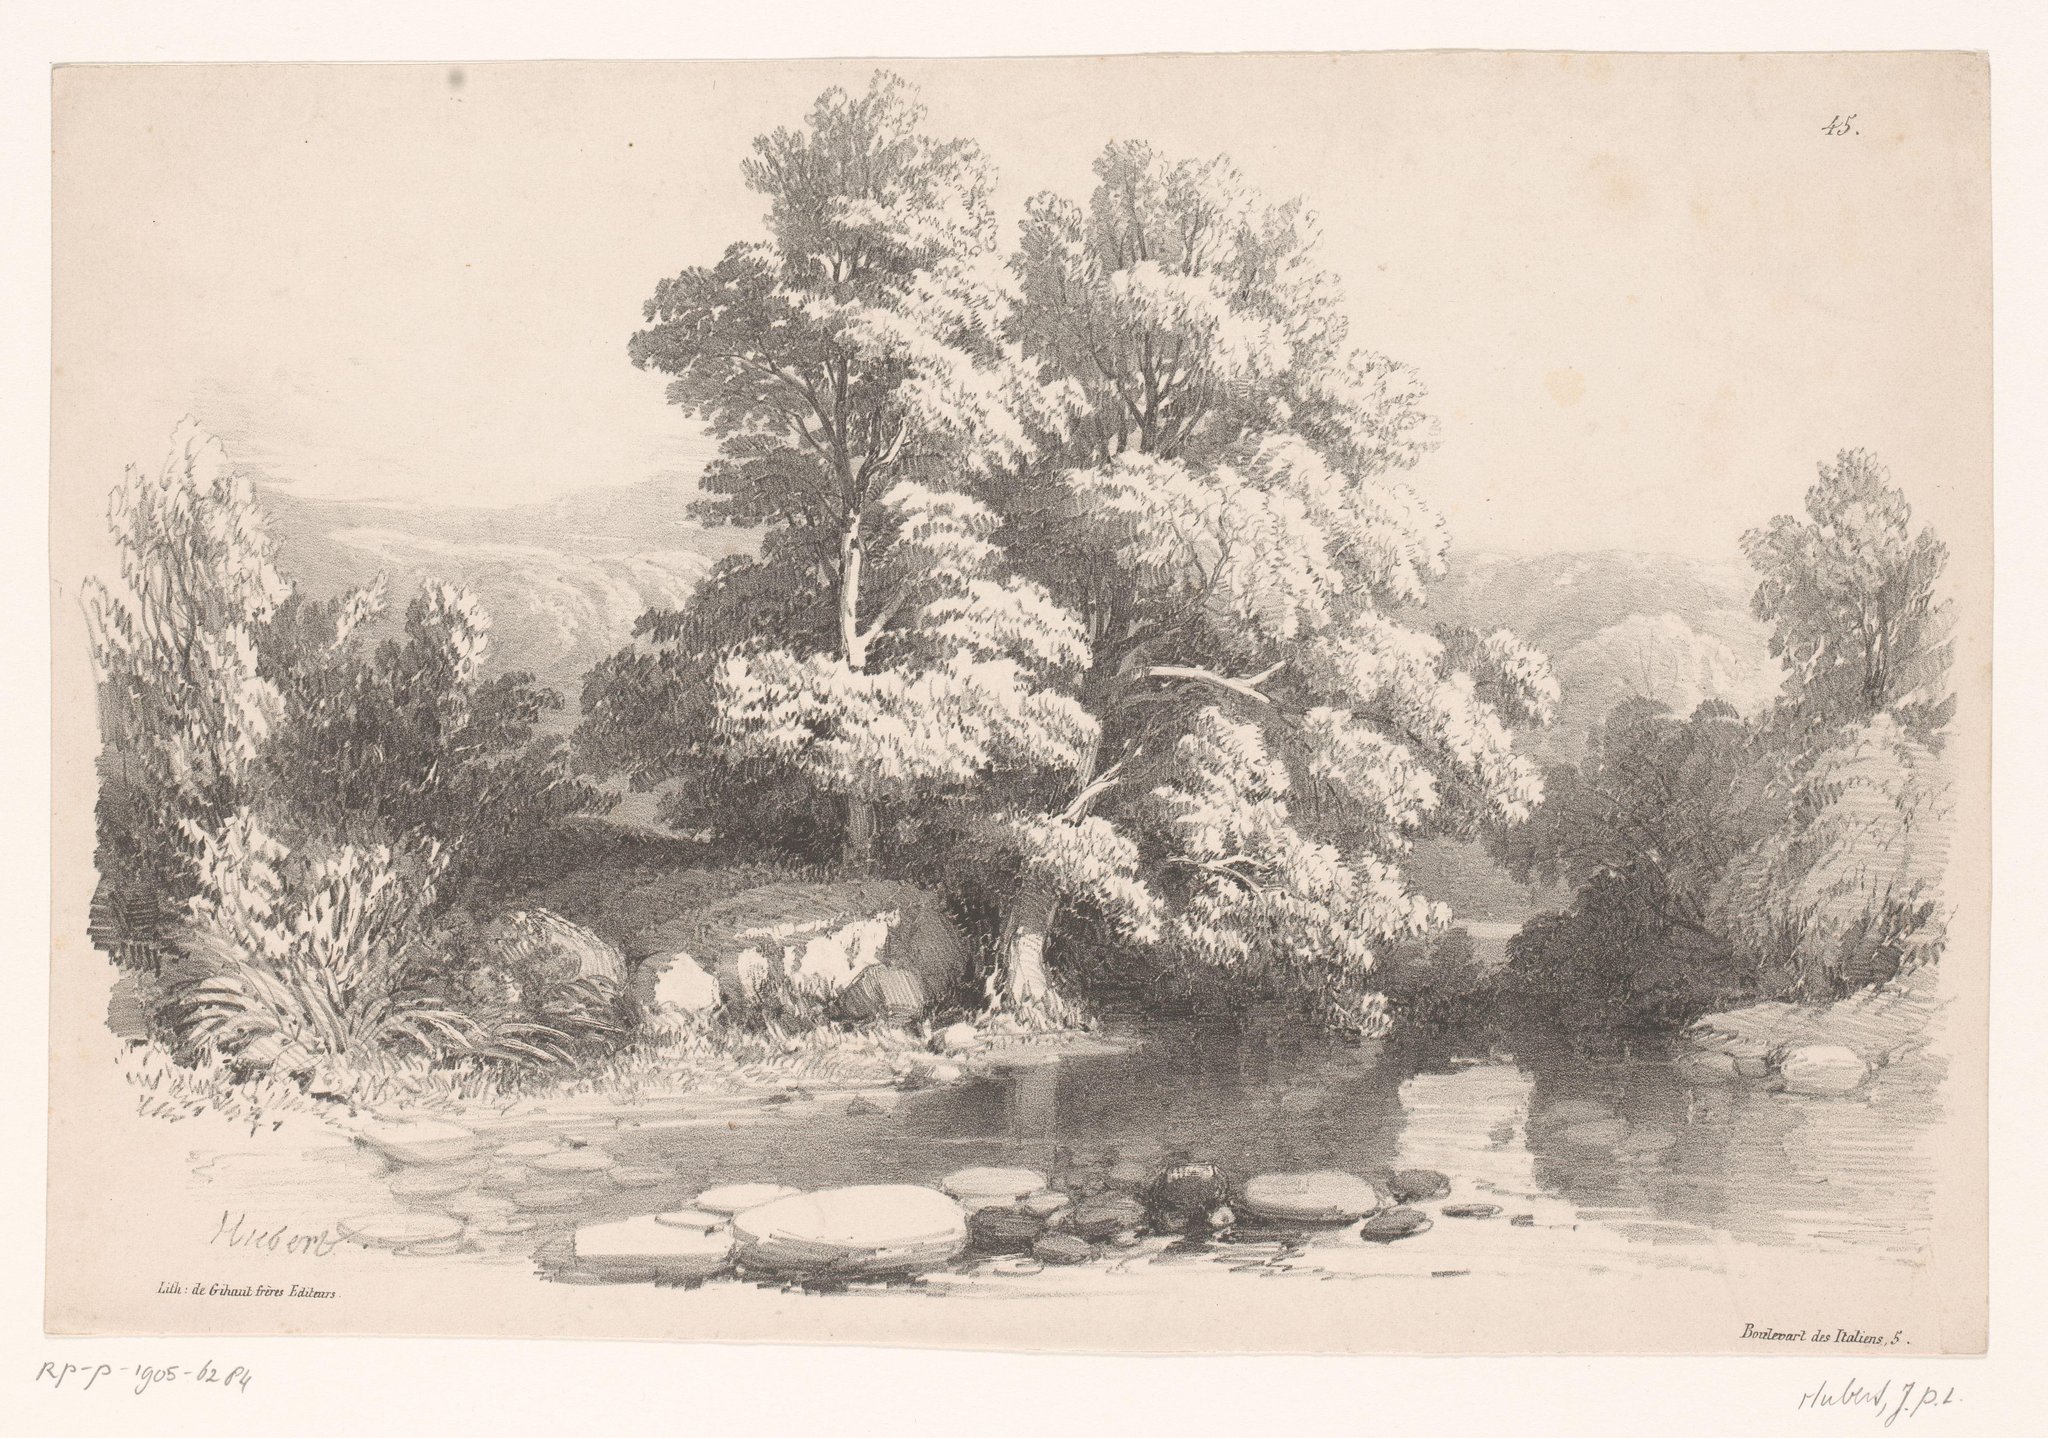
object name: print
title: Berglandschap met bomen en vijver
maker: jean baptiste louis hubert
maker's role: print maker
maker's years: 1801-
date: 1834-1838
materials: paper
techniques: lithograph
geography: paris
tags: trees, pond, pool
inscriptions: collector's mark: Lugt 2228a